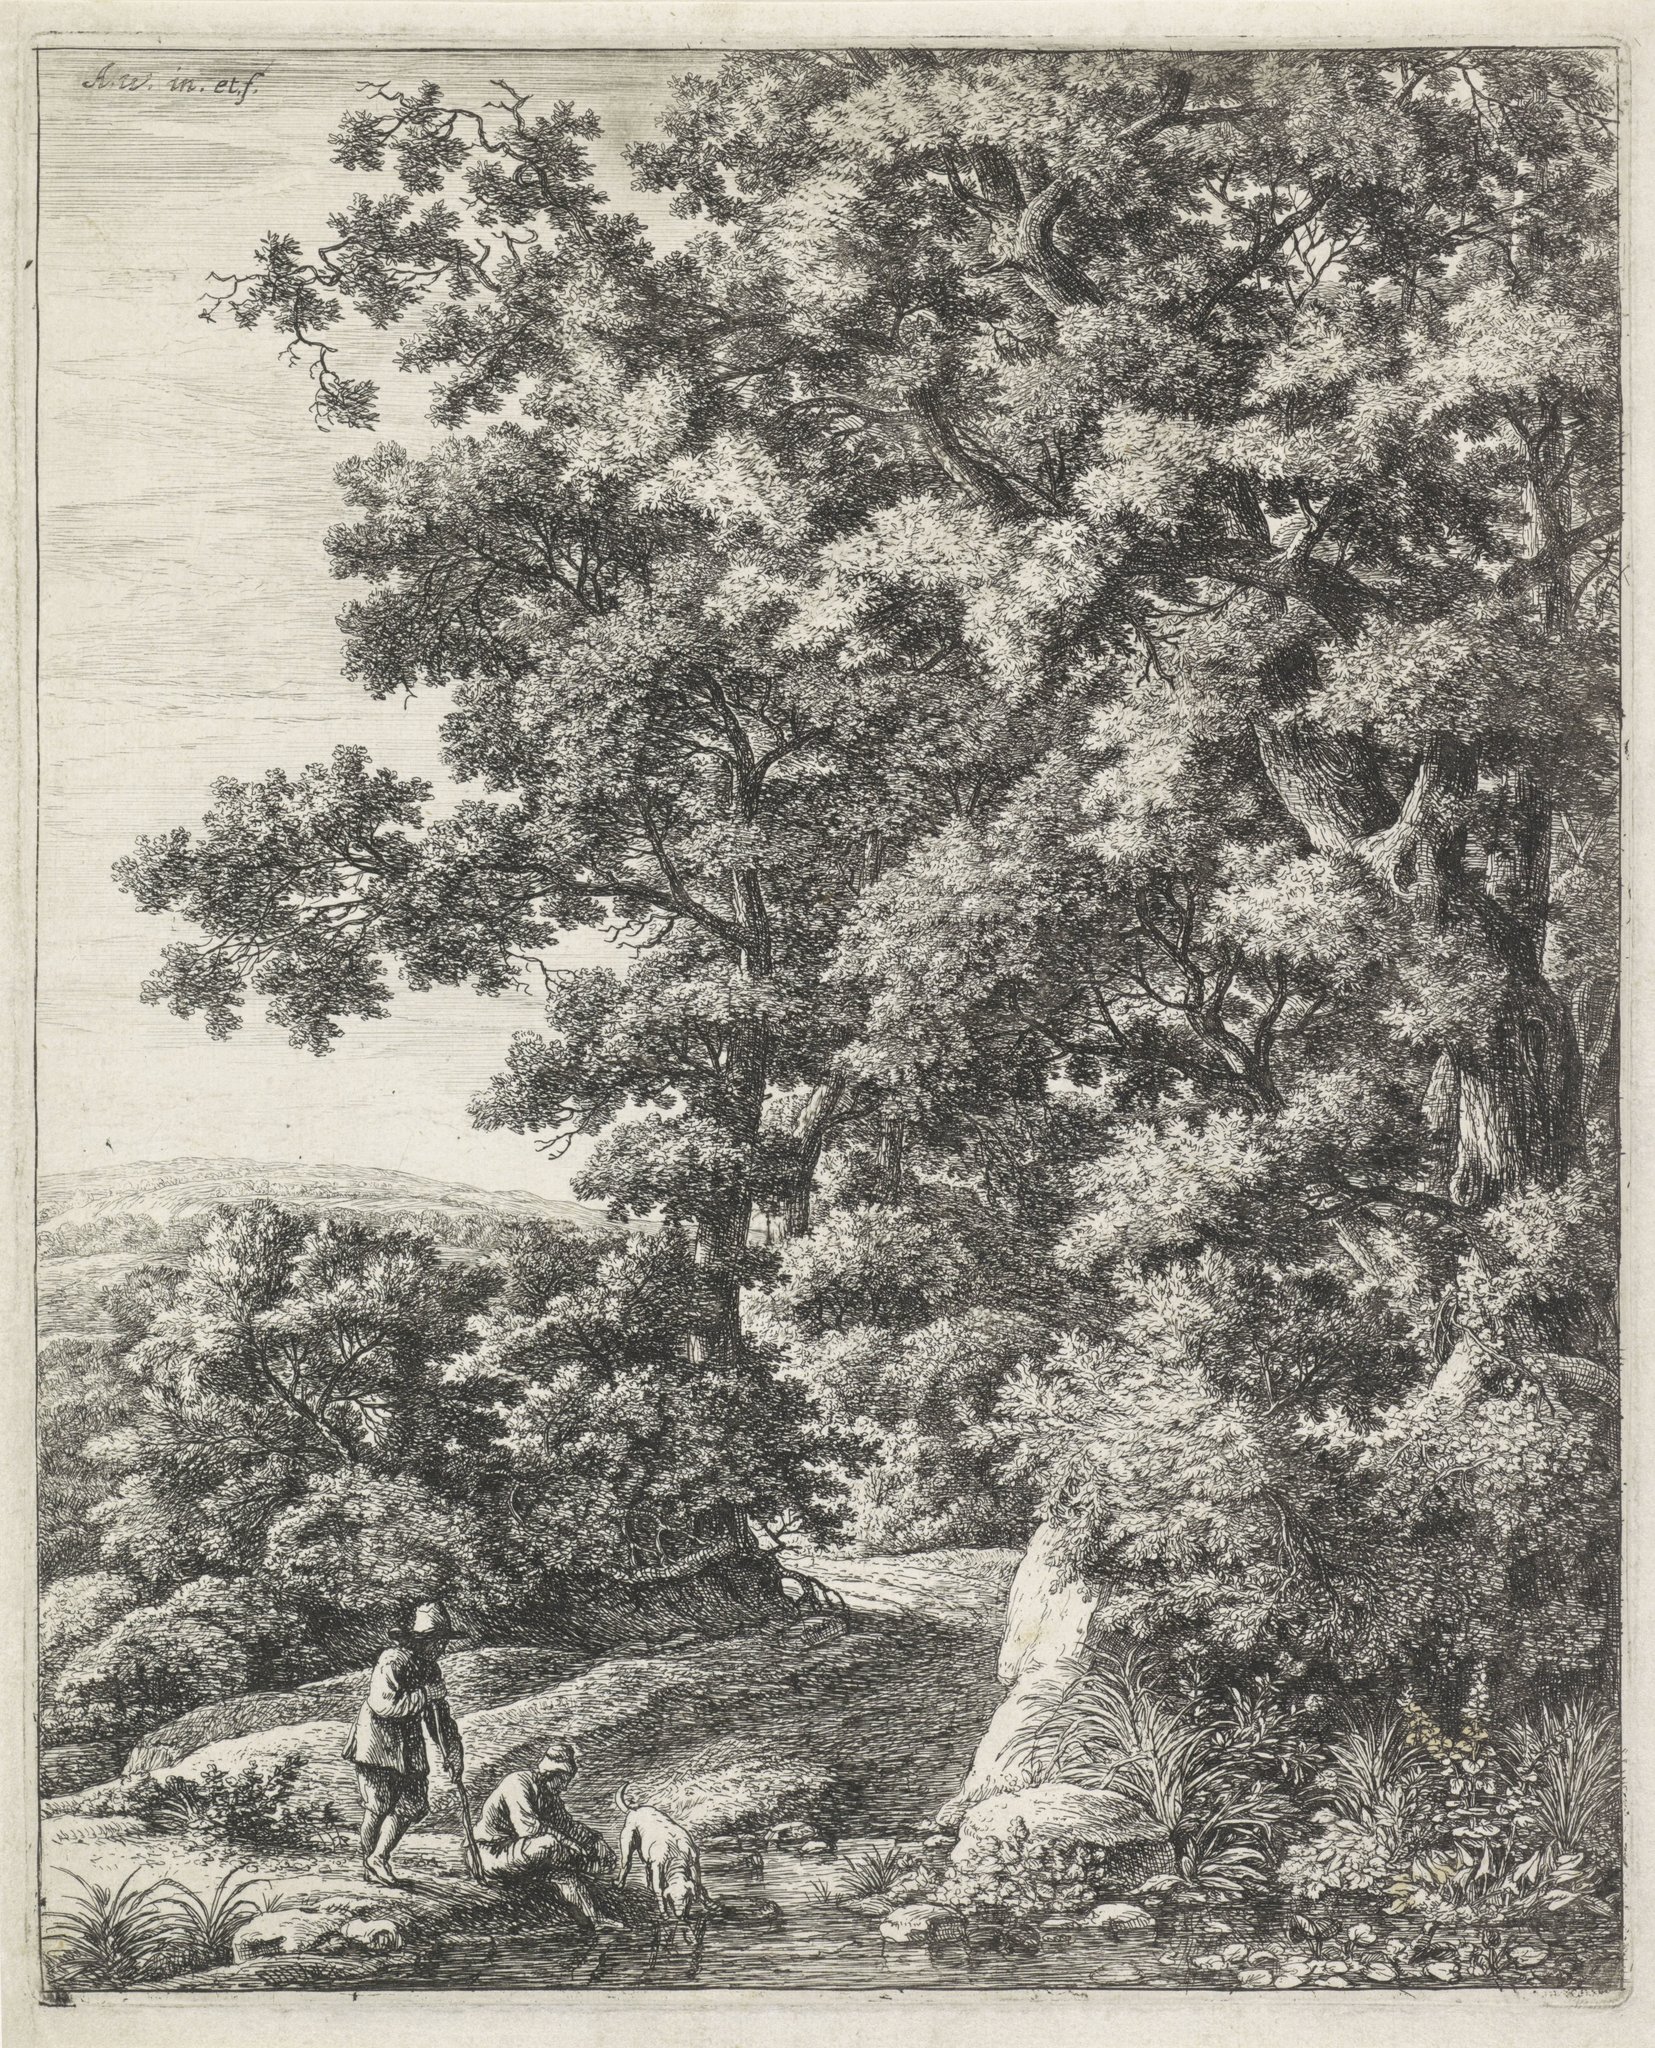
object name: print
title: Staande landschappen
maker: anthonie waterloo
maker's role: draughtsman, painter, print maker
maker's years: 1609-1690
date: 1630-1663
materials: paper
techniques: etching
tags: brook, watermill in landscape, drinking, 'en route', traveller under way, dog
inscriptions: collector's mark: Lugt 240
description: Aan de rand van een bos rusten twee figuren langs een pad. Voor hen drinkt een hond uit de beek.